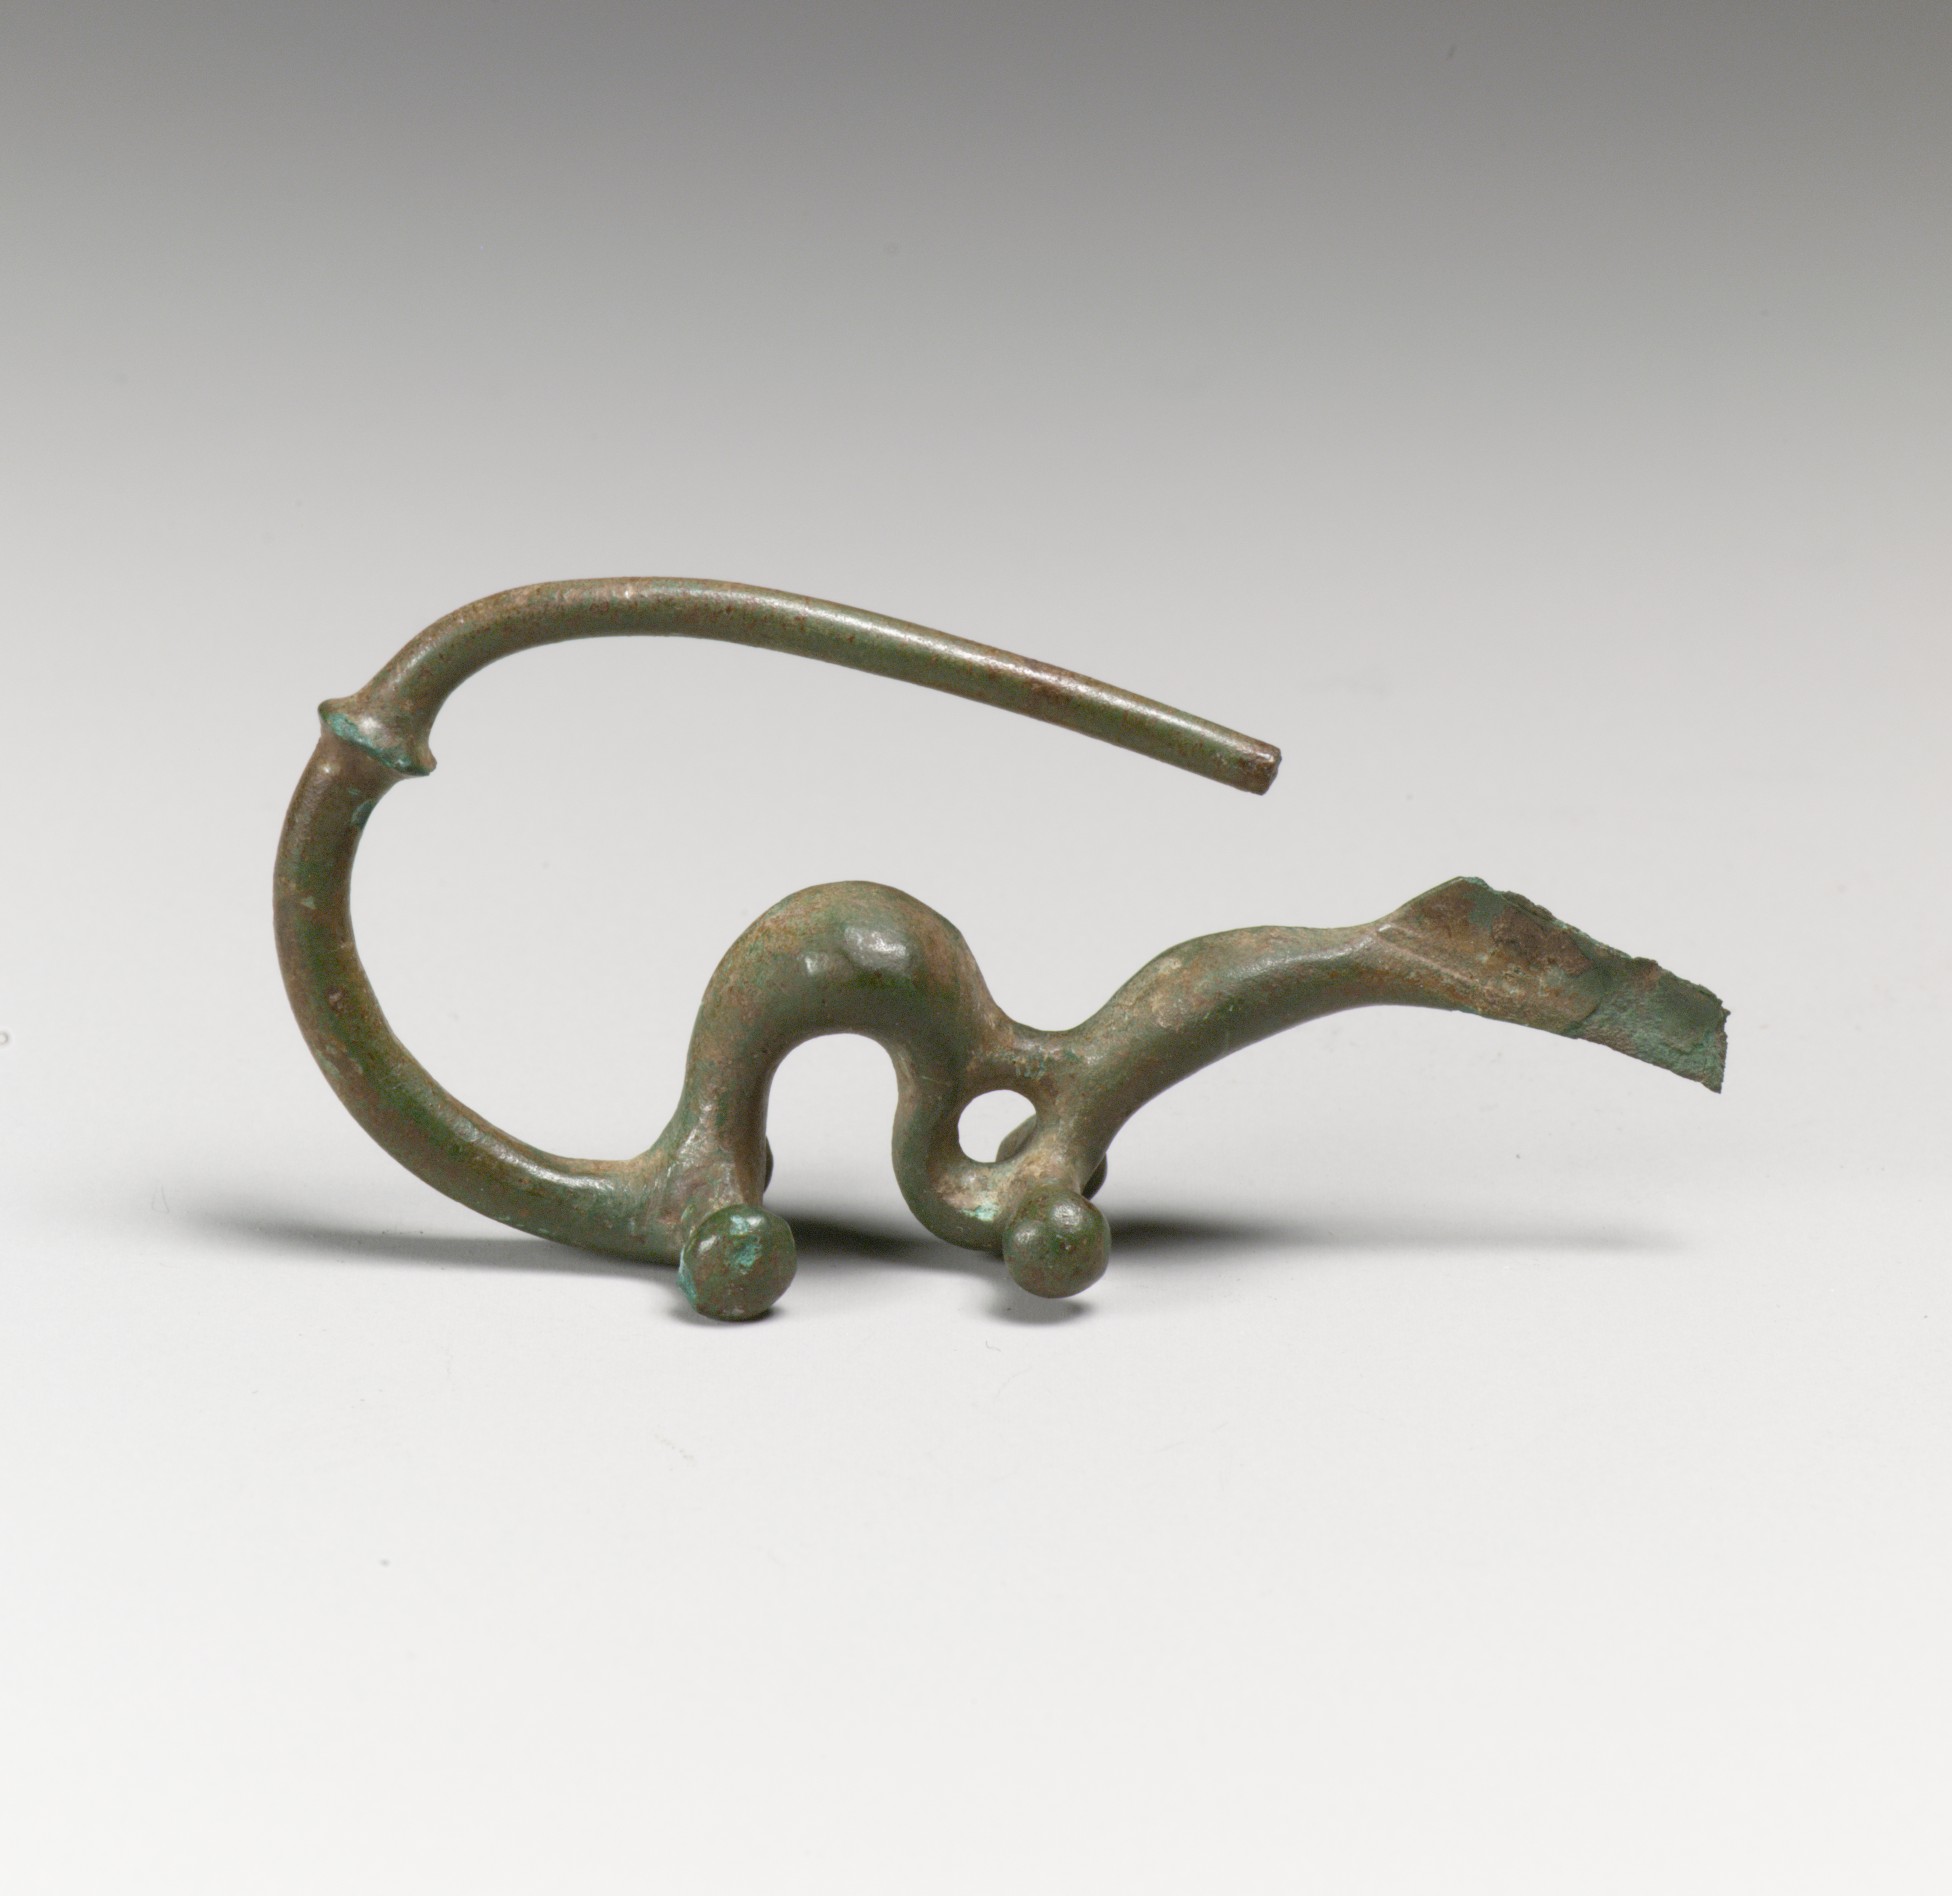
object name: fibula, serpentine type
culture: italic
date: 700-501 BCE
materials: bronze